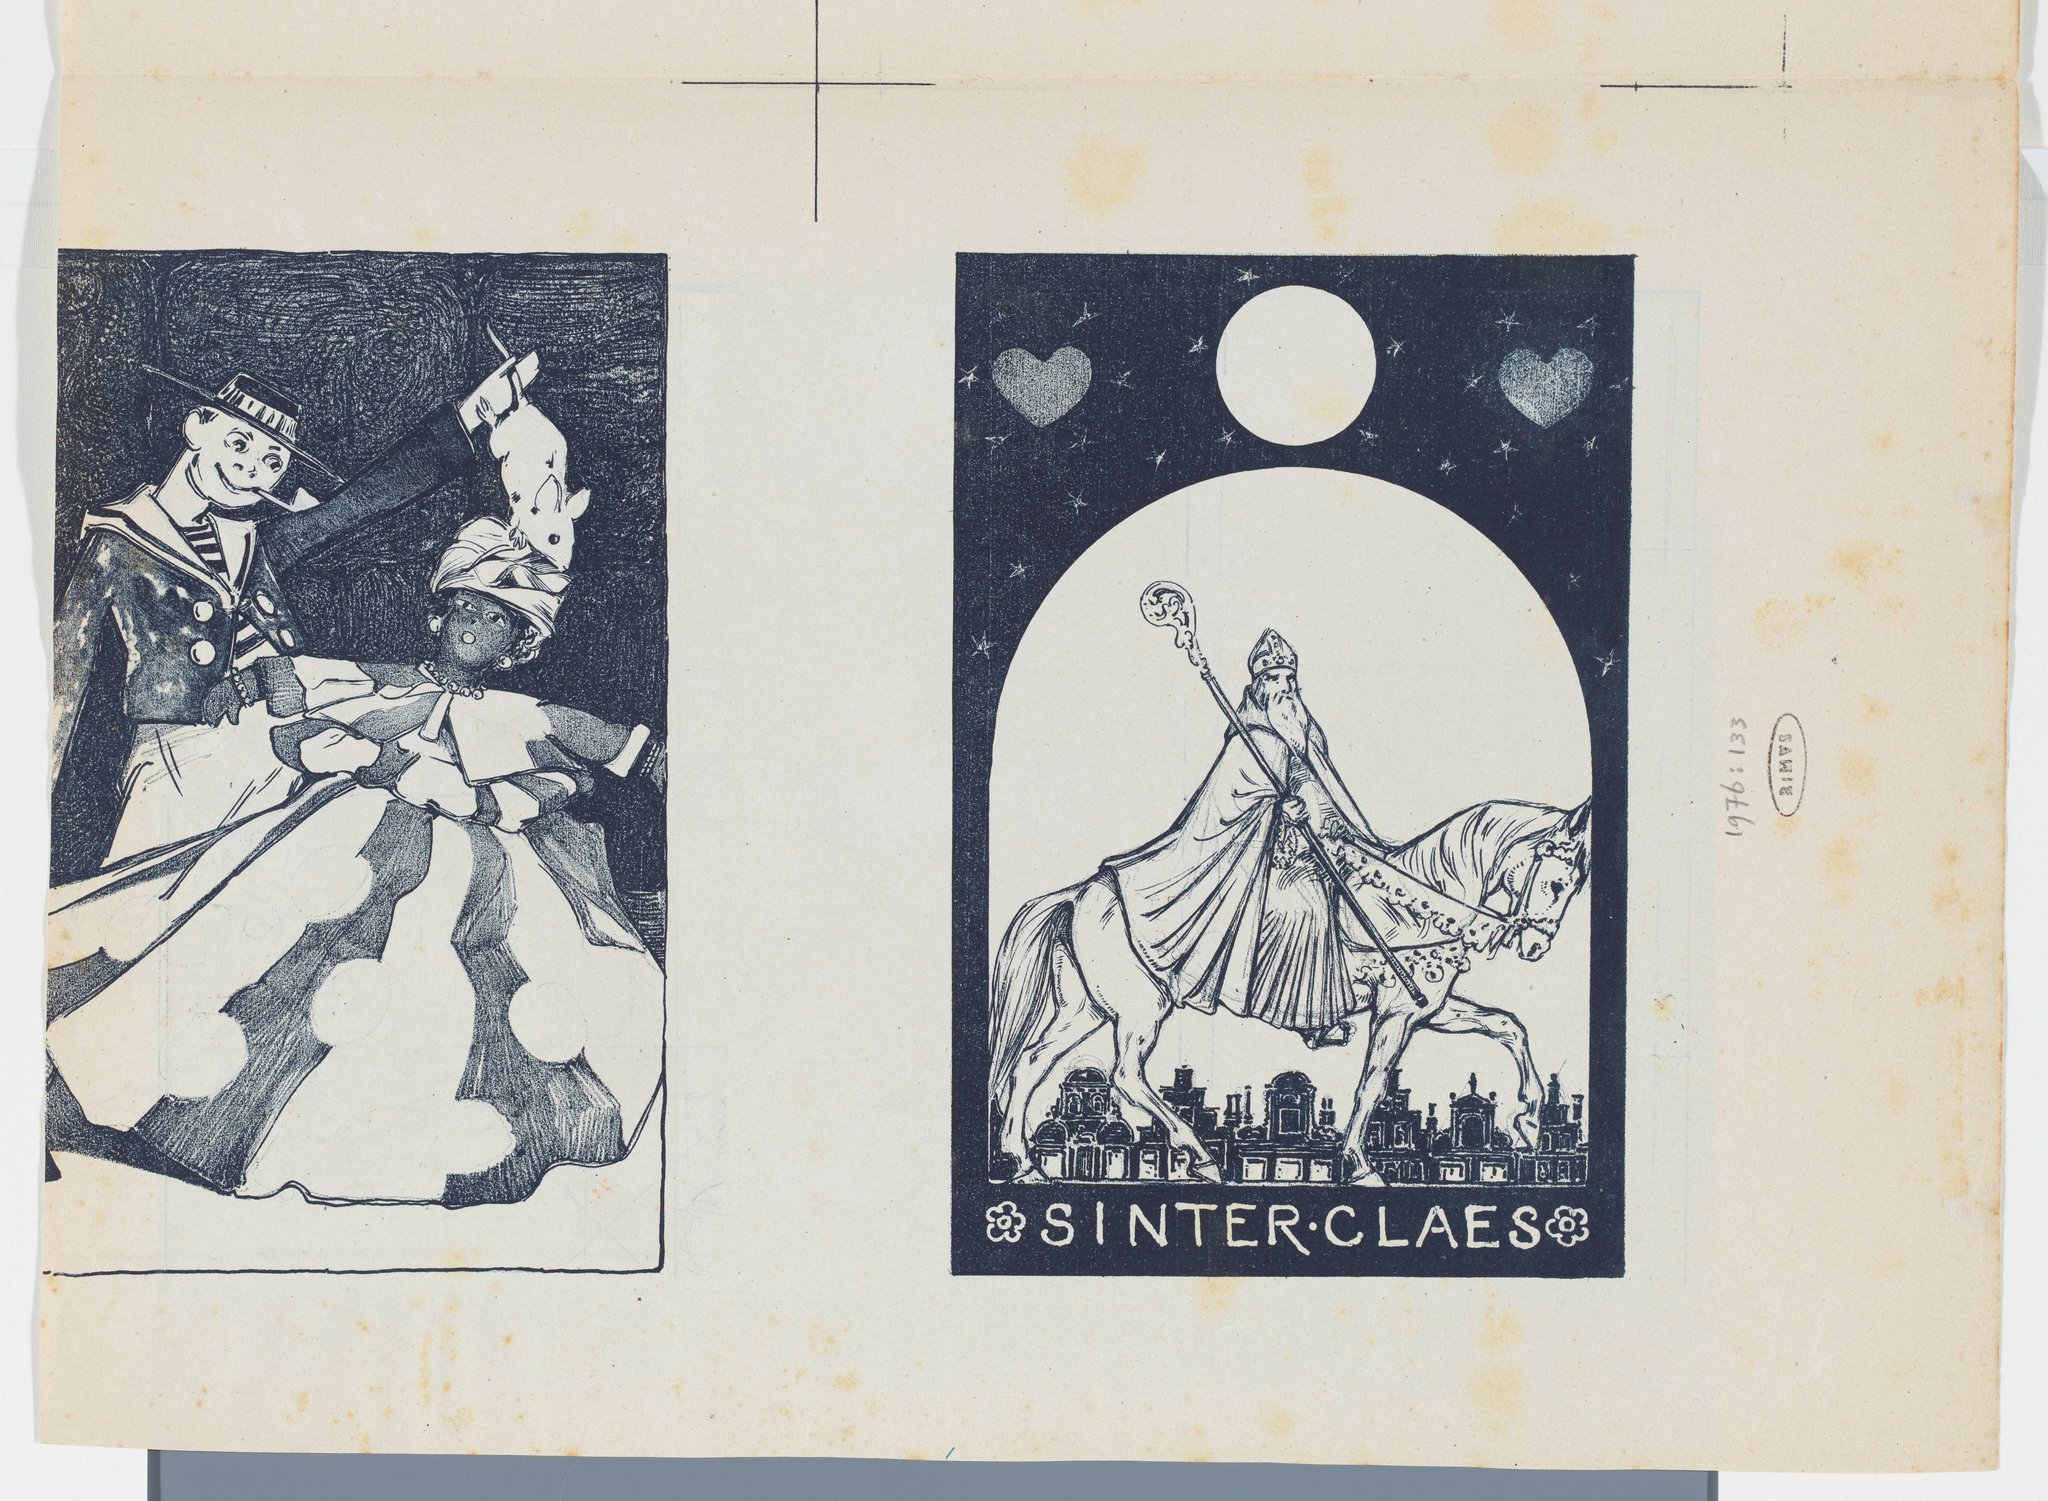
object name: design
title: Isegrim voor koning Nobel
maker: bernard willem wierink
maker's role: draughtsman, print maker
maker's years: 1856-1939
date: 1866-1939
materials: ink, paper, pencil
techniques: brush, pen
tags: fable of reynard the fox, beasts of prey, predatory animals: wolf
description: Ontwerp voor illustratie (fol. 4, eerste ontwerp): Van den Vos Reinaerde; Isegrim, de wolf, voor koning Nobel.